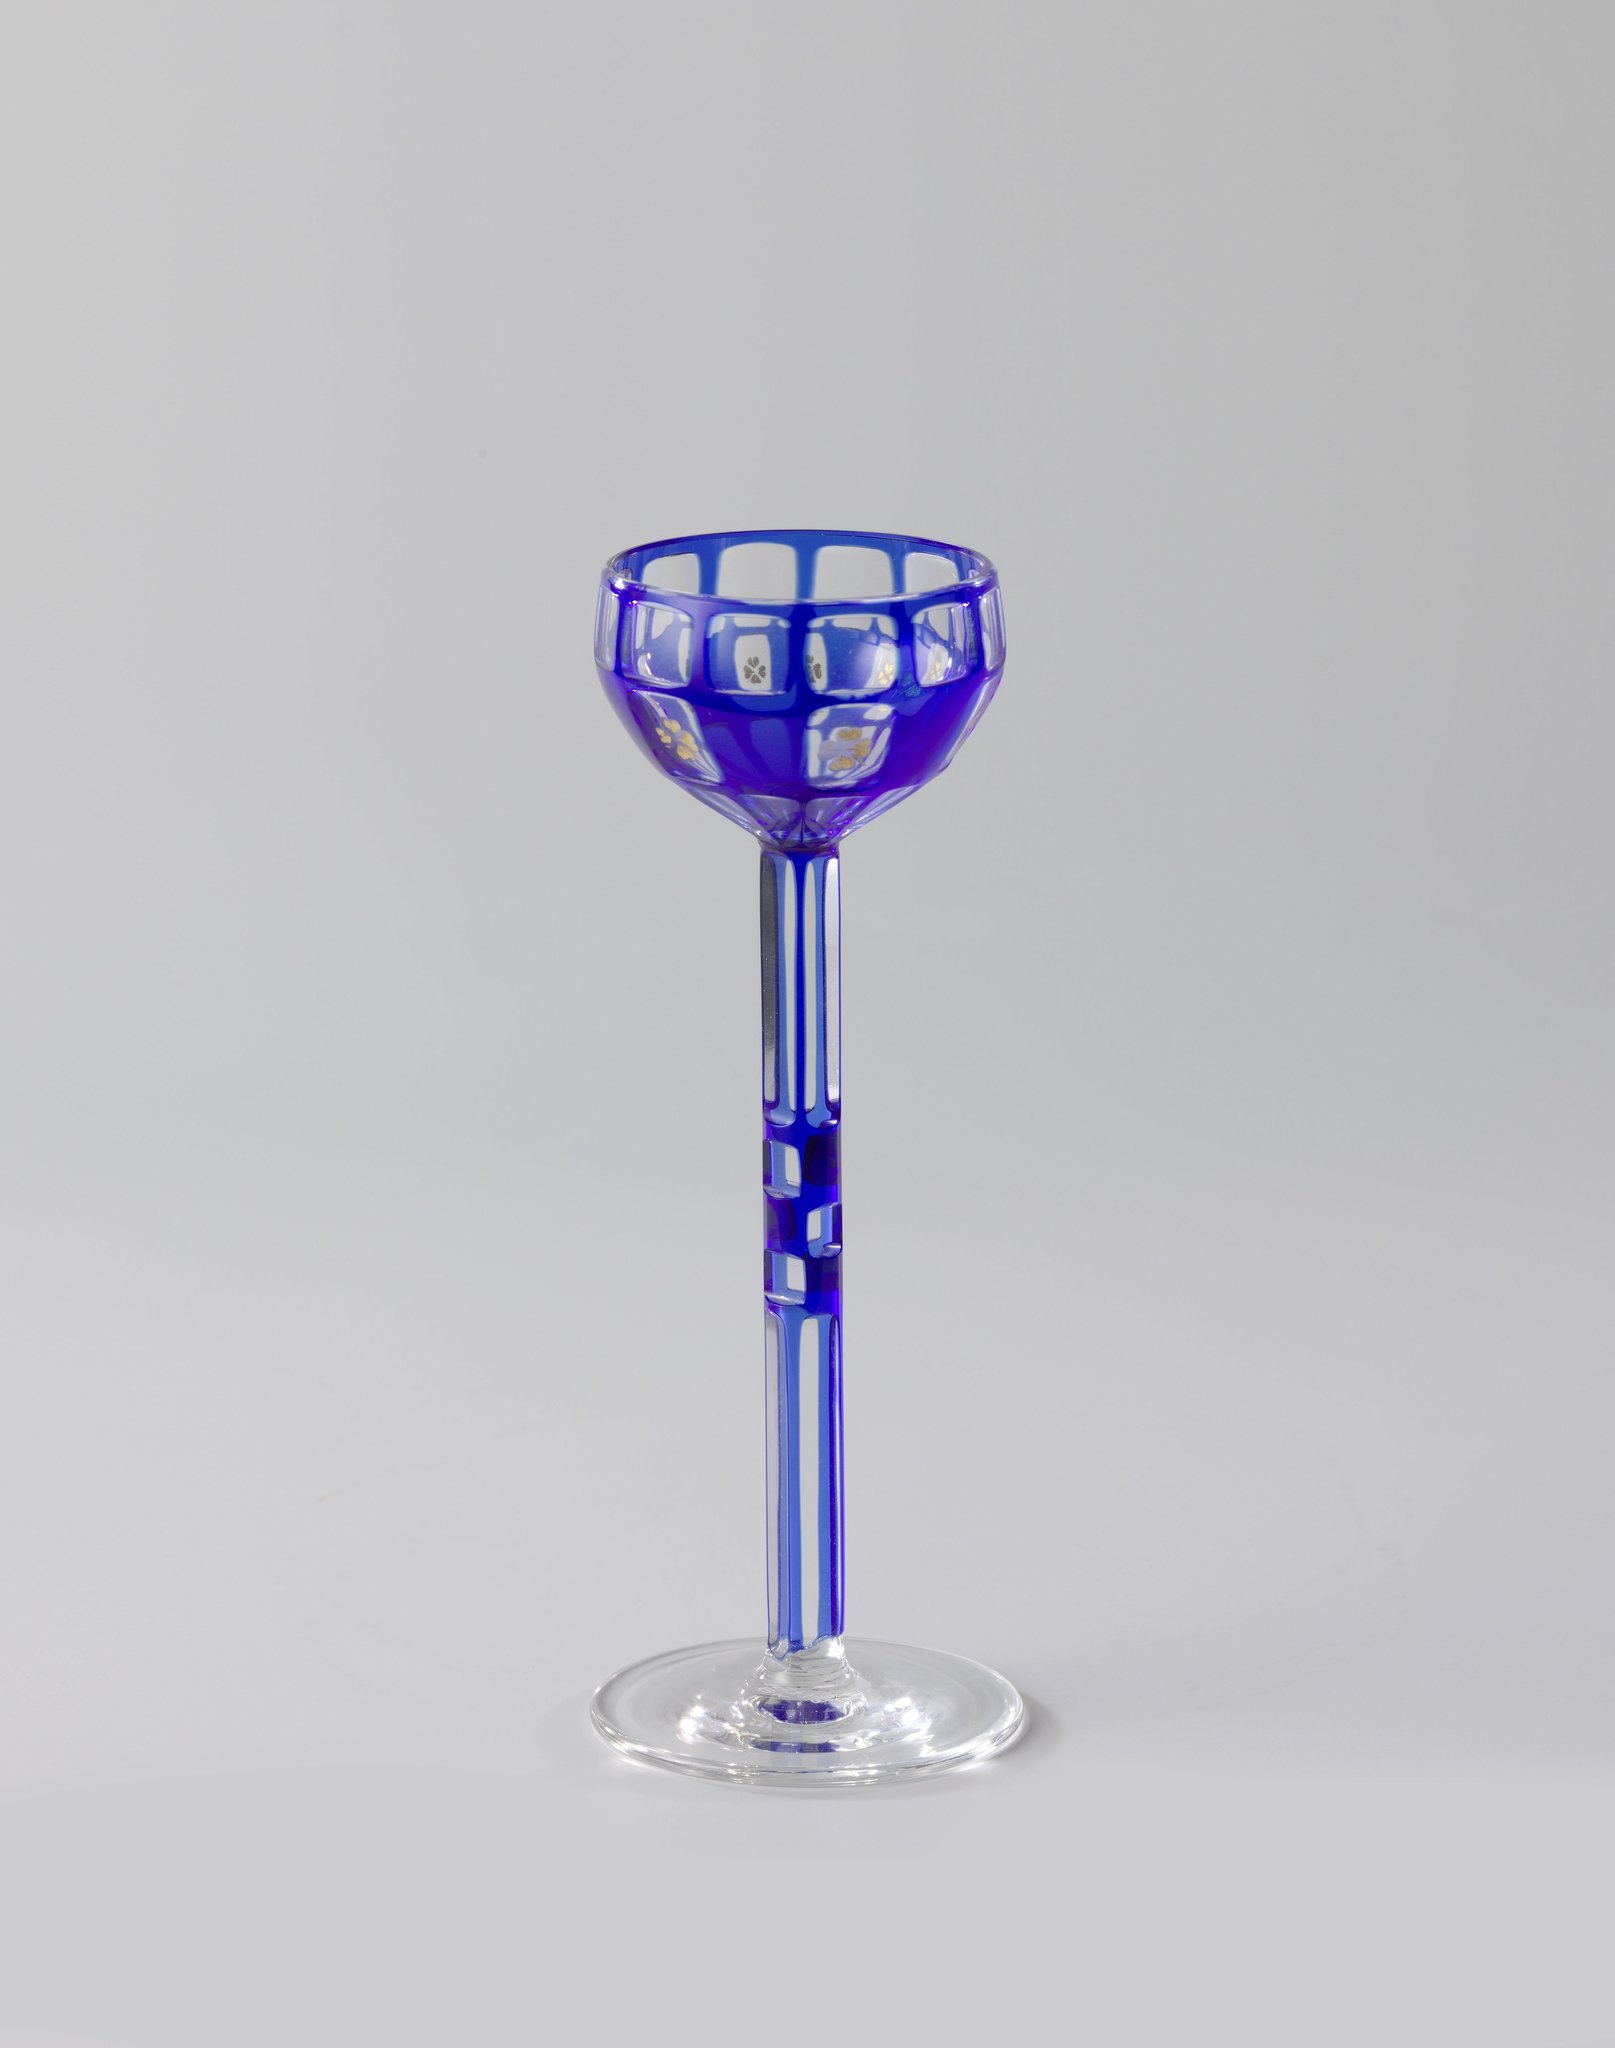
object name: liqueur glass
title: Likeurglas met blauwe Überfang met weggeslepen vierkanten en rechthoeken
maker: otto prutscher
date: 1907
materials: glass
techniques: gilding, glassblowing, grinding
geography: vienna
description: Platte voet, slanke, vierkantige stam, gebogen kelk. Stam en kelk met een blauwe Überfang, weggeslepen in een geometrisch patroon van vierkanten en rechthoeken. In de middelste rij vierkanten op de kelk vergulde klaverbloempjes.